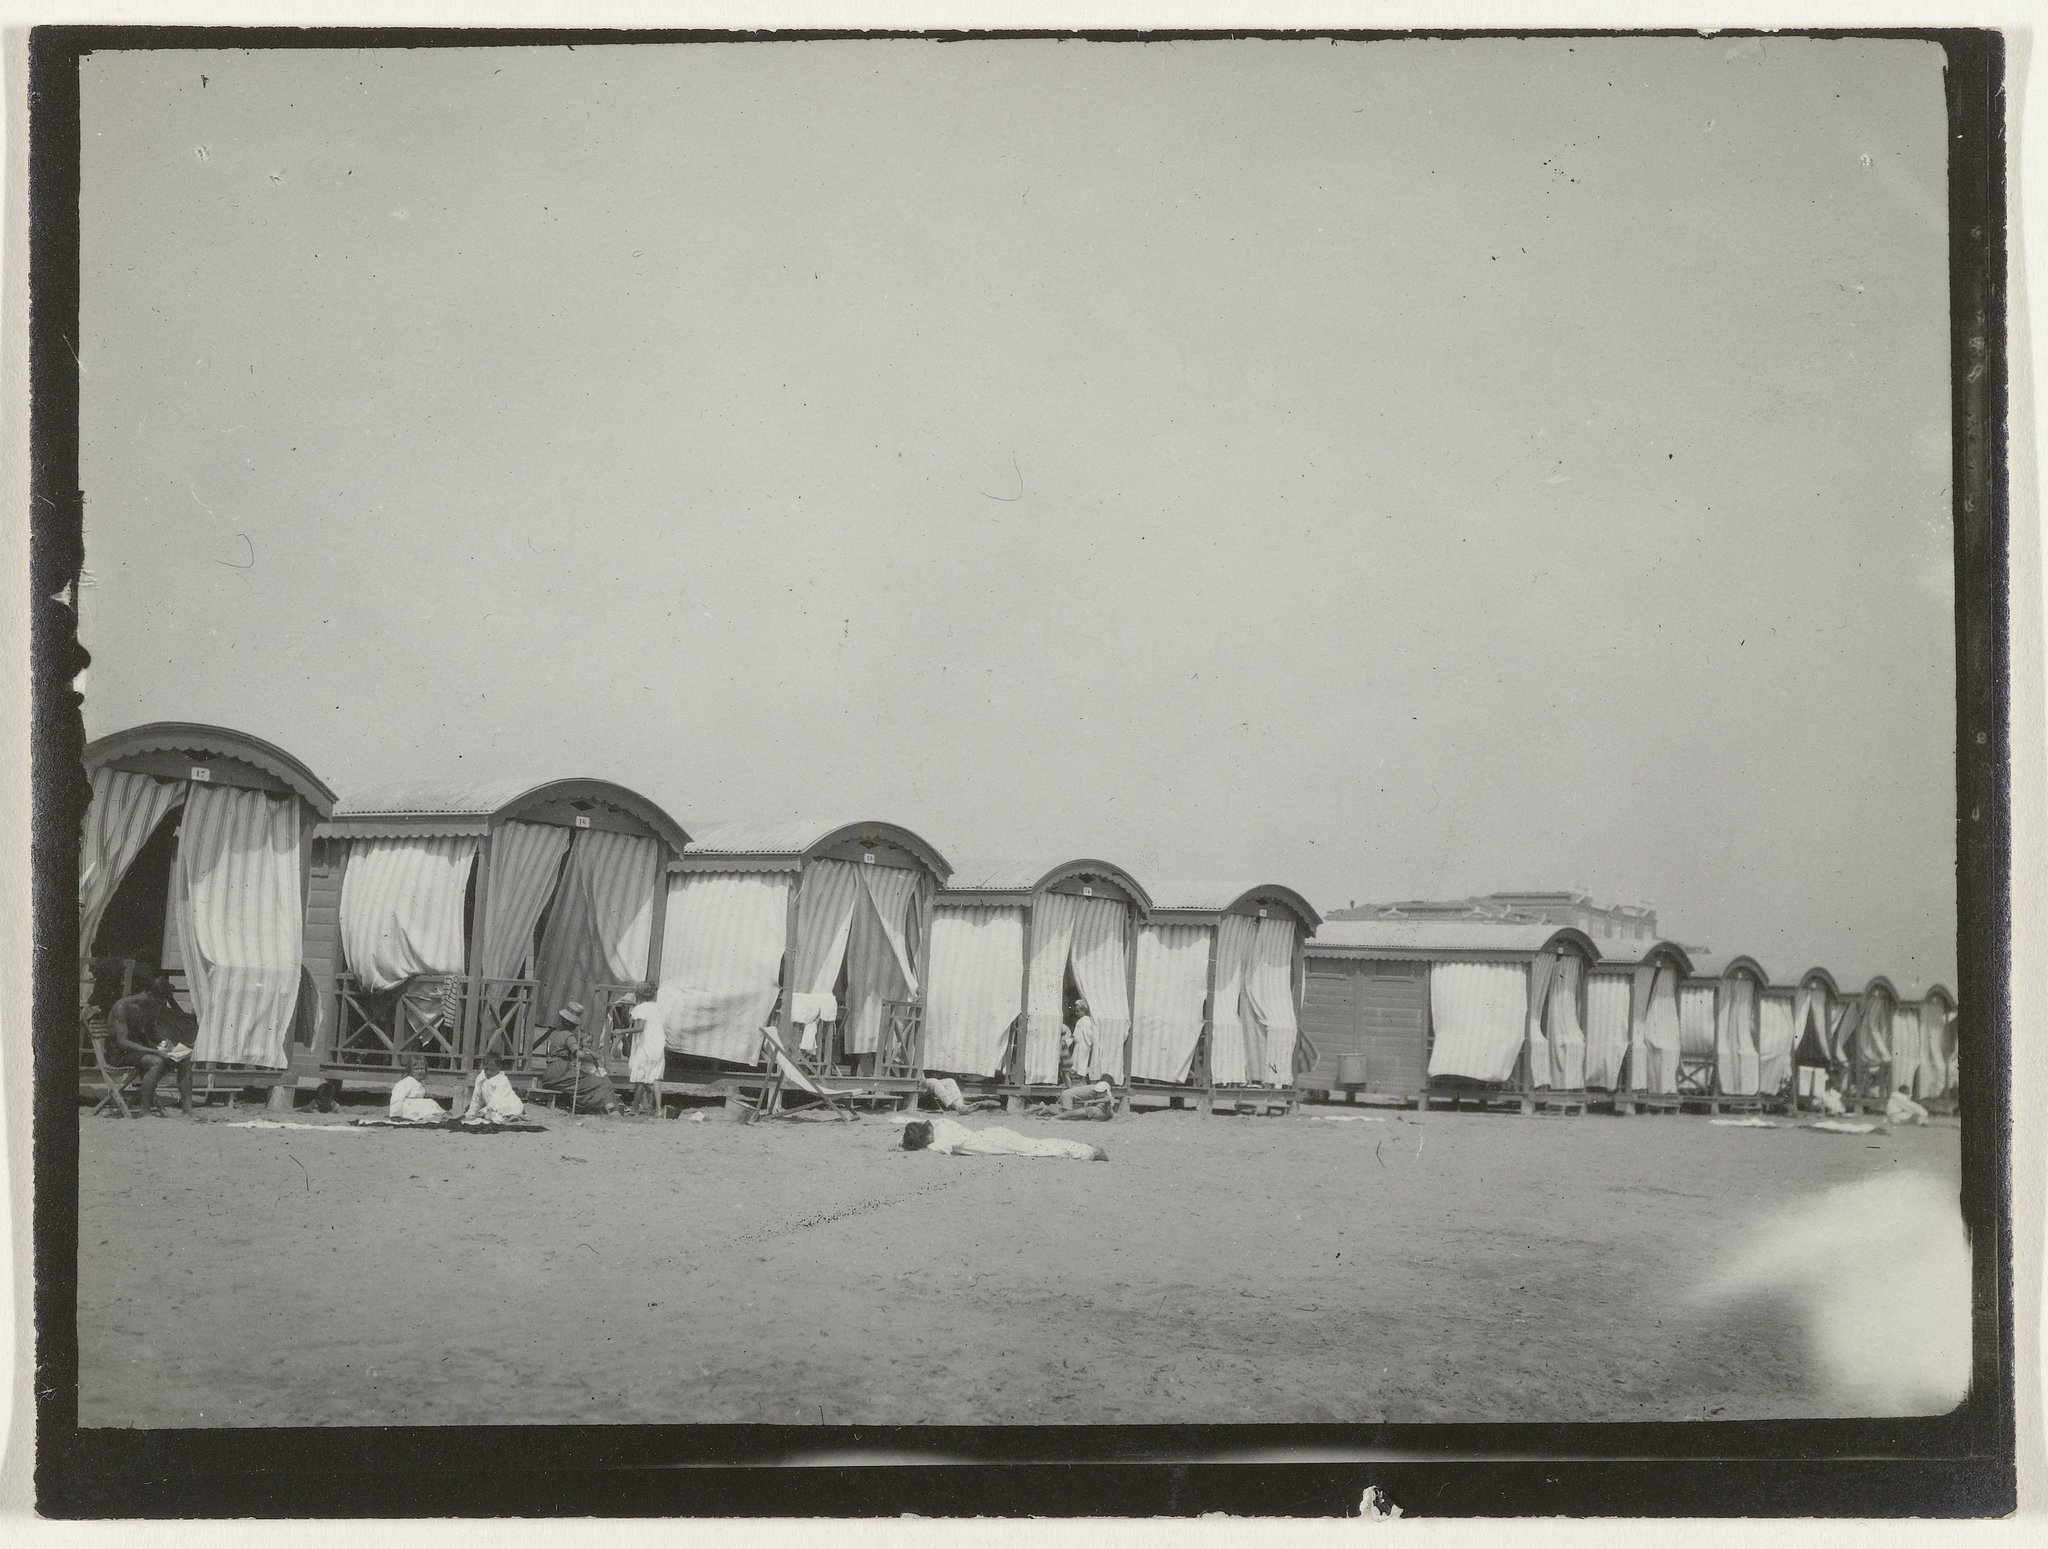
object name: photograph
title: Strandhuisjes (Noordzeekust), Nederland of Duitsland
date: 1900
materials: paper, photographic support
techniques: gelatin silver print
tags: beach (as place of recreation), netherlands, germany